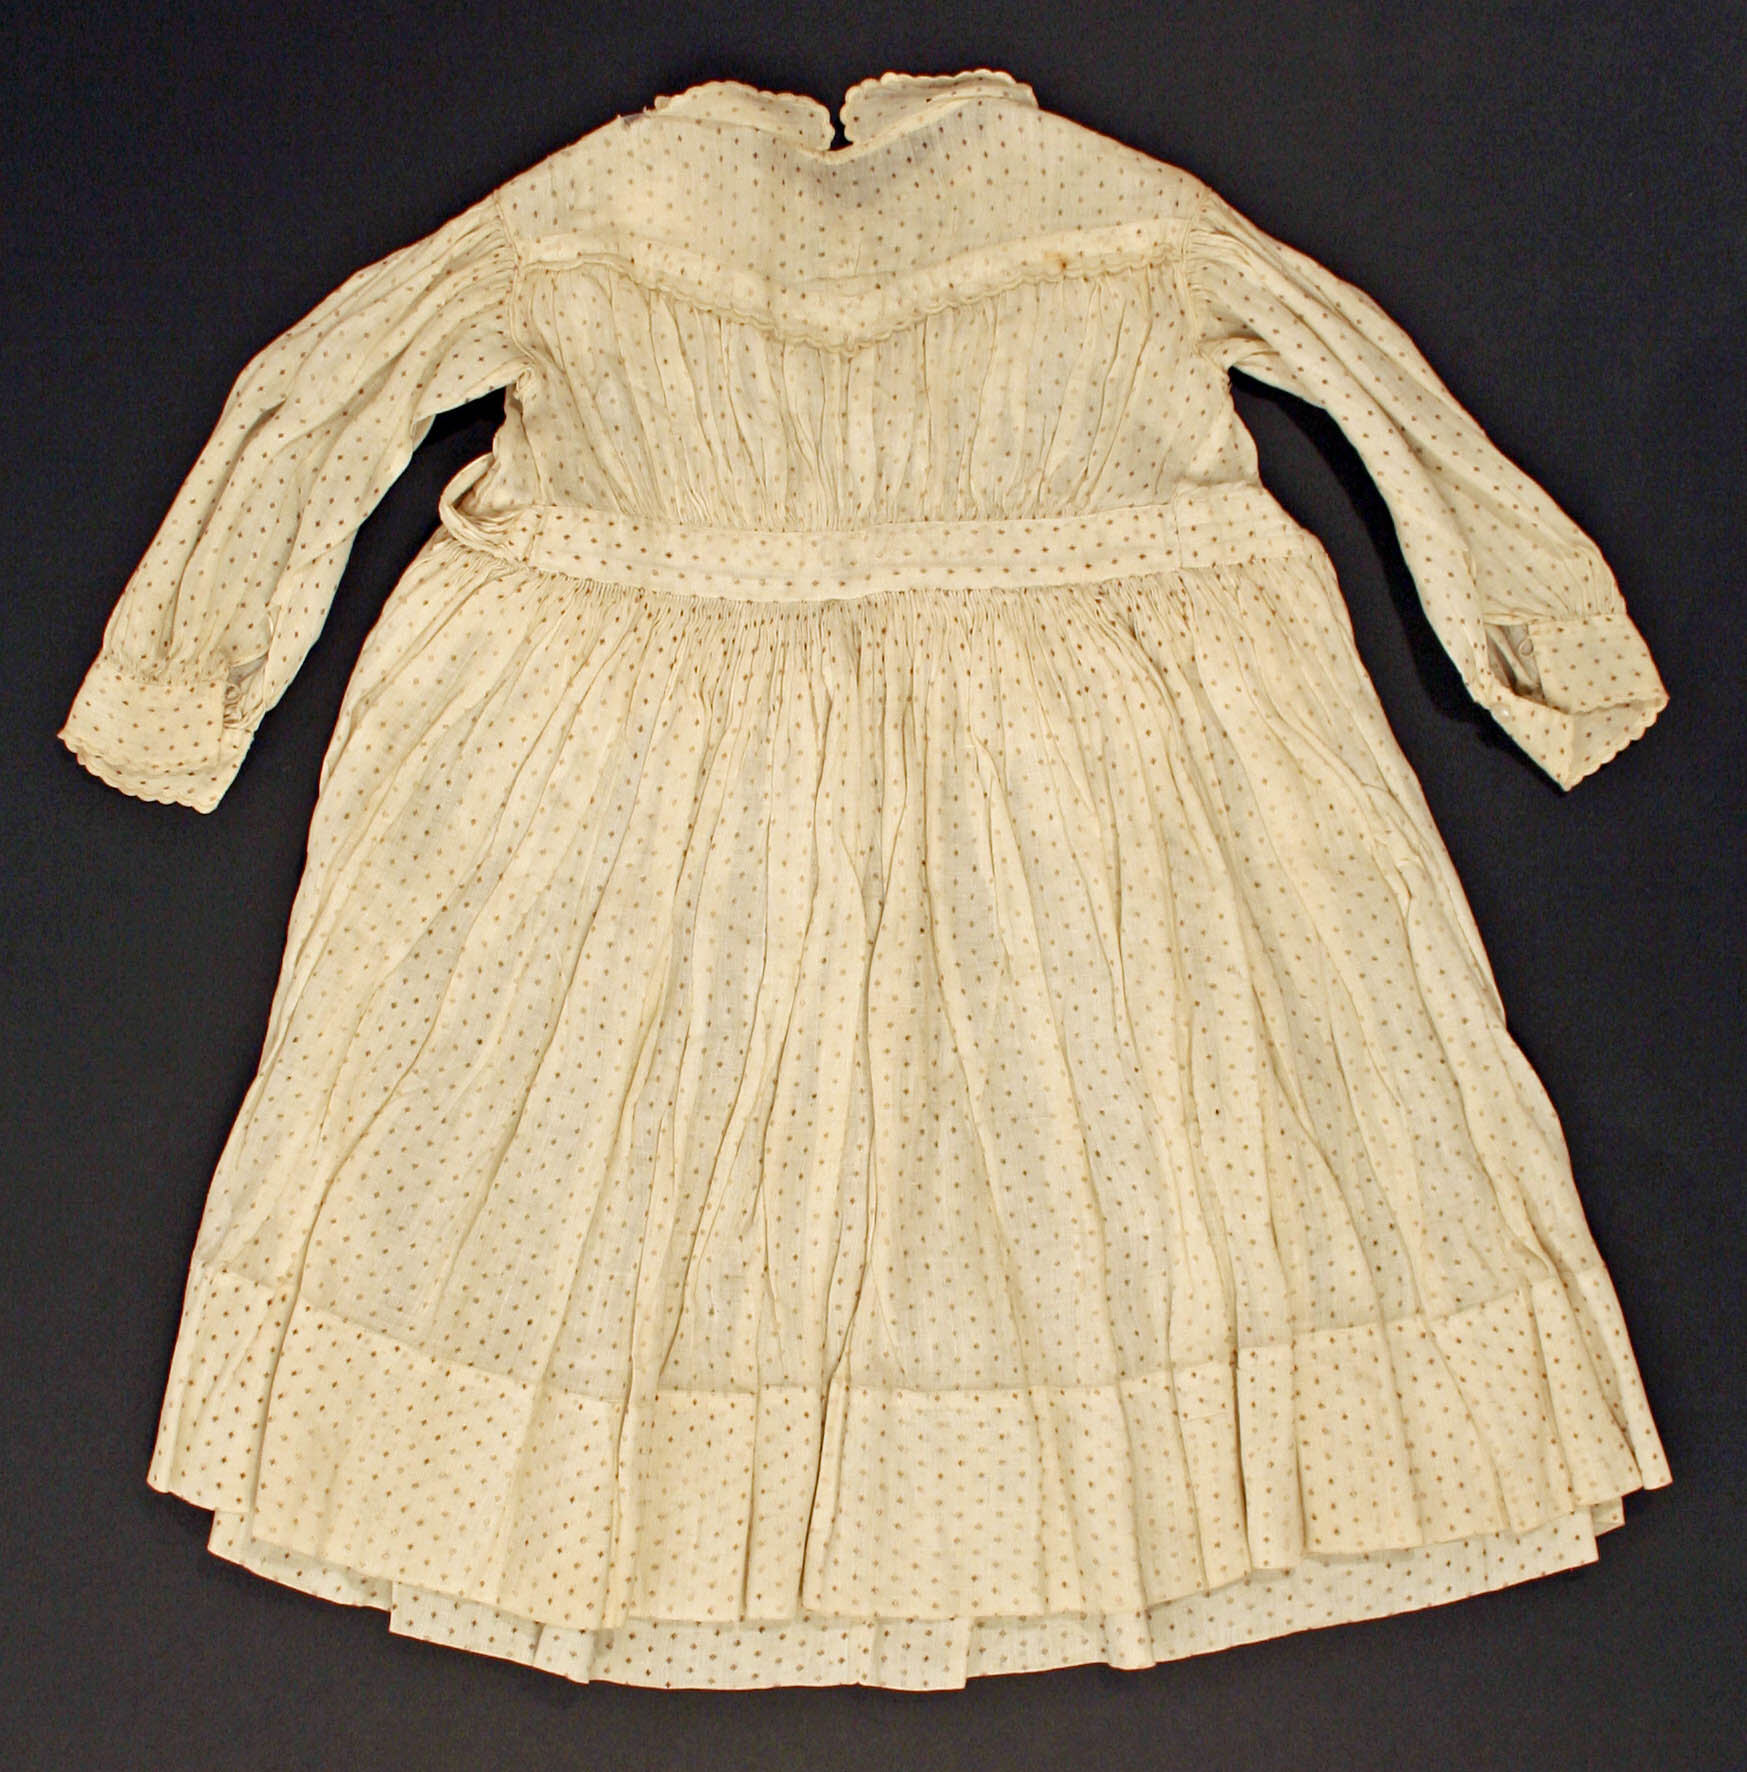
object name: dress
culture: american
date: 1860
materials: cotton